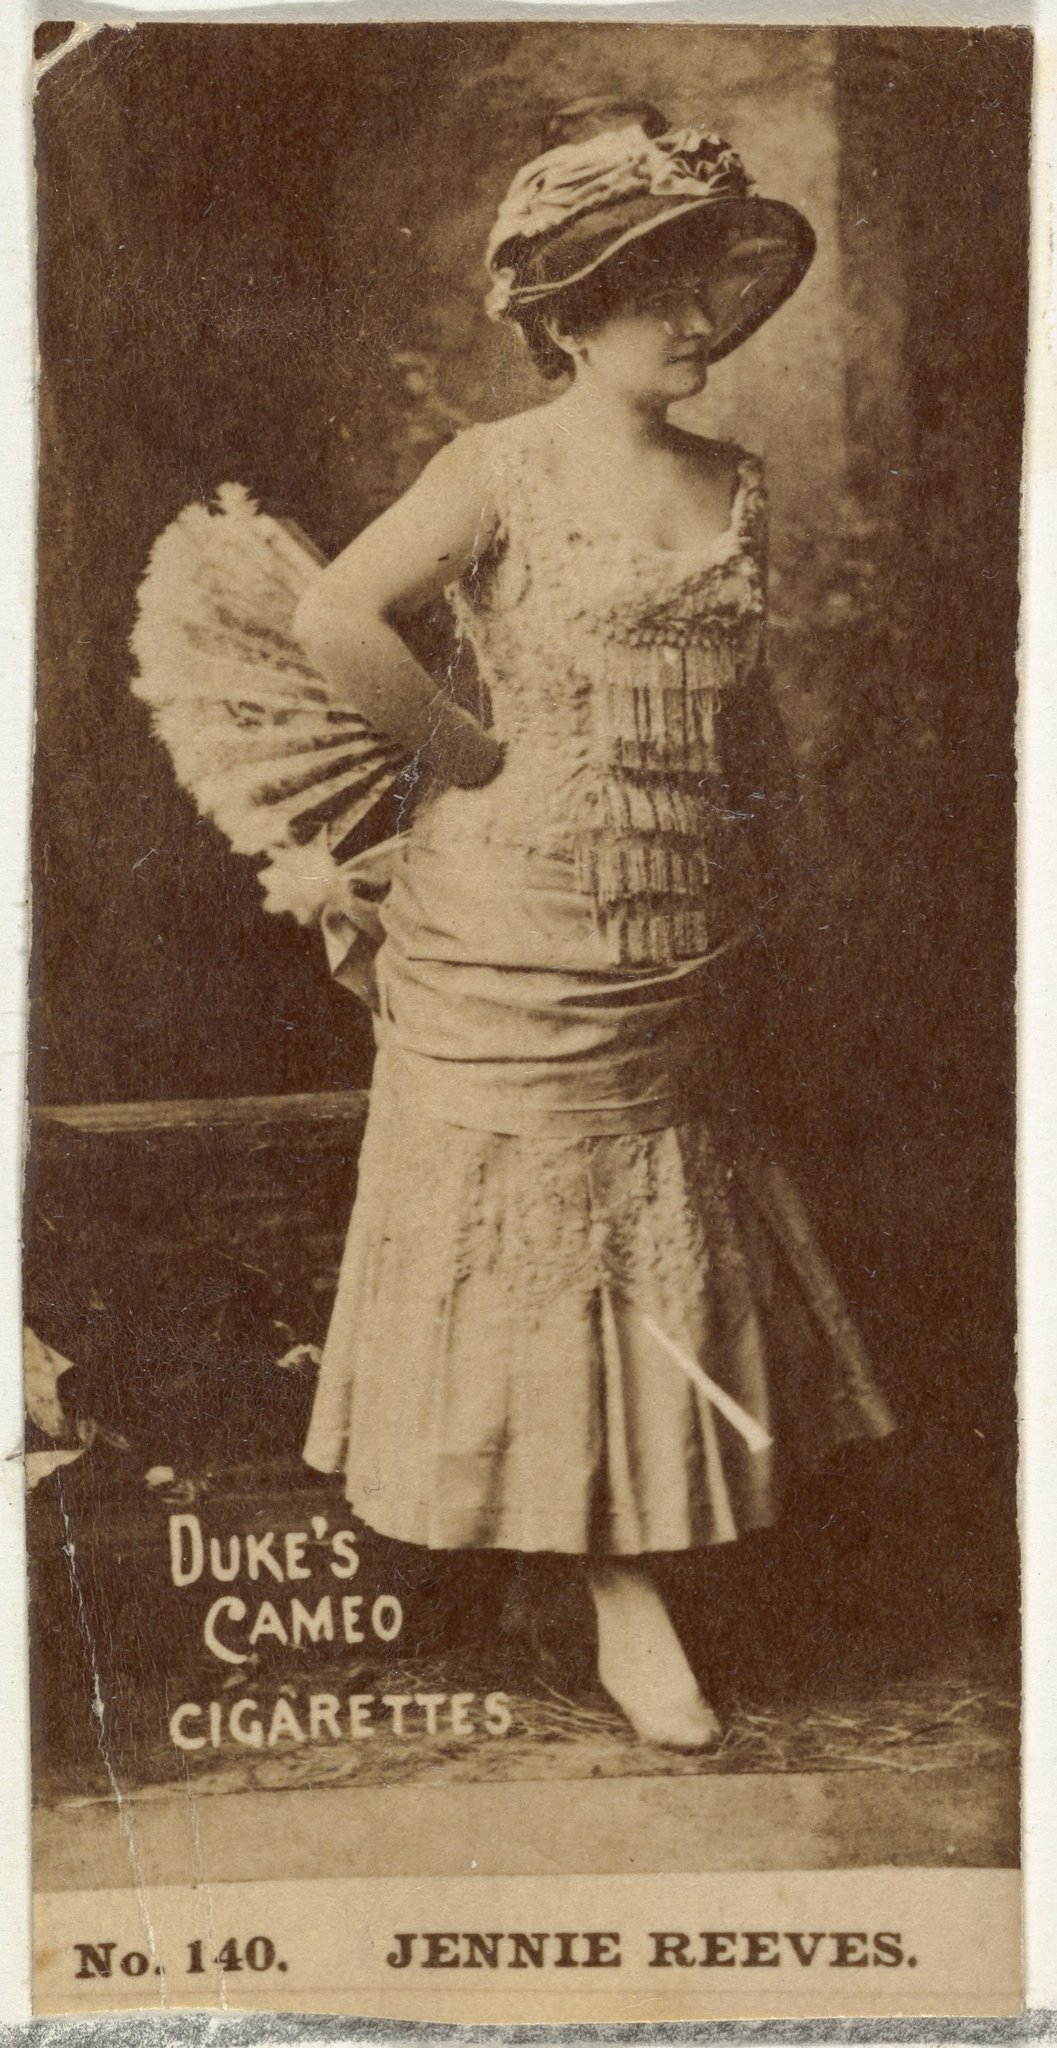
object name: photograph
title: Card Number 140, Jennie Reeves, from the Actors and Actresses series (N145-4) issued by Duke Sons & Co. to promote Cameo Cigarettes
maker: w. duke, sons & co.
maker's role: publisher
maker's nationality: american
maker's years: 1870-1920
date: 1880-1889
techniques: albumen silver print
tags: portraits,women,actresses